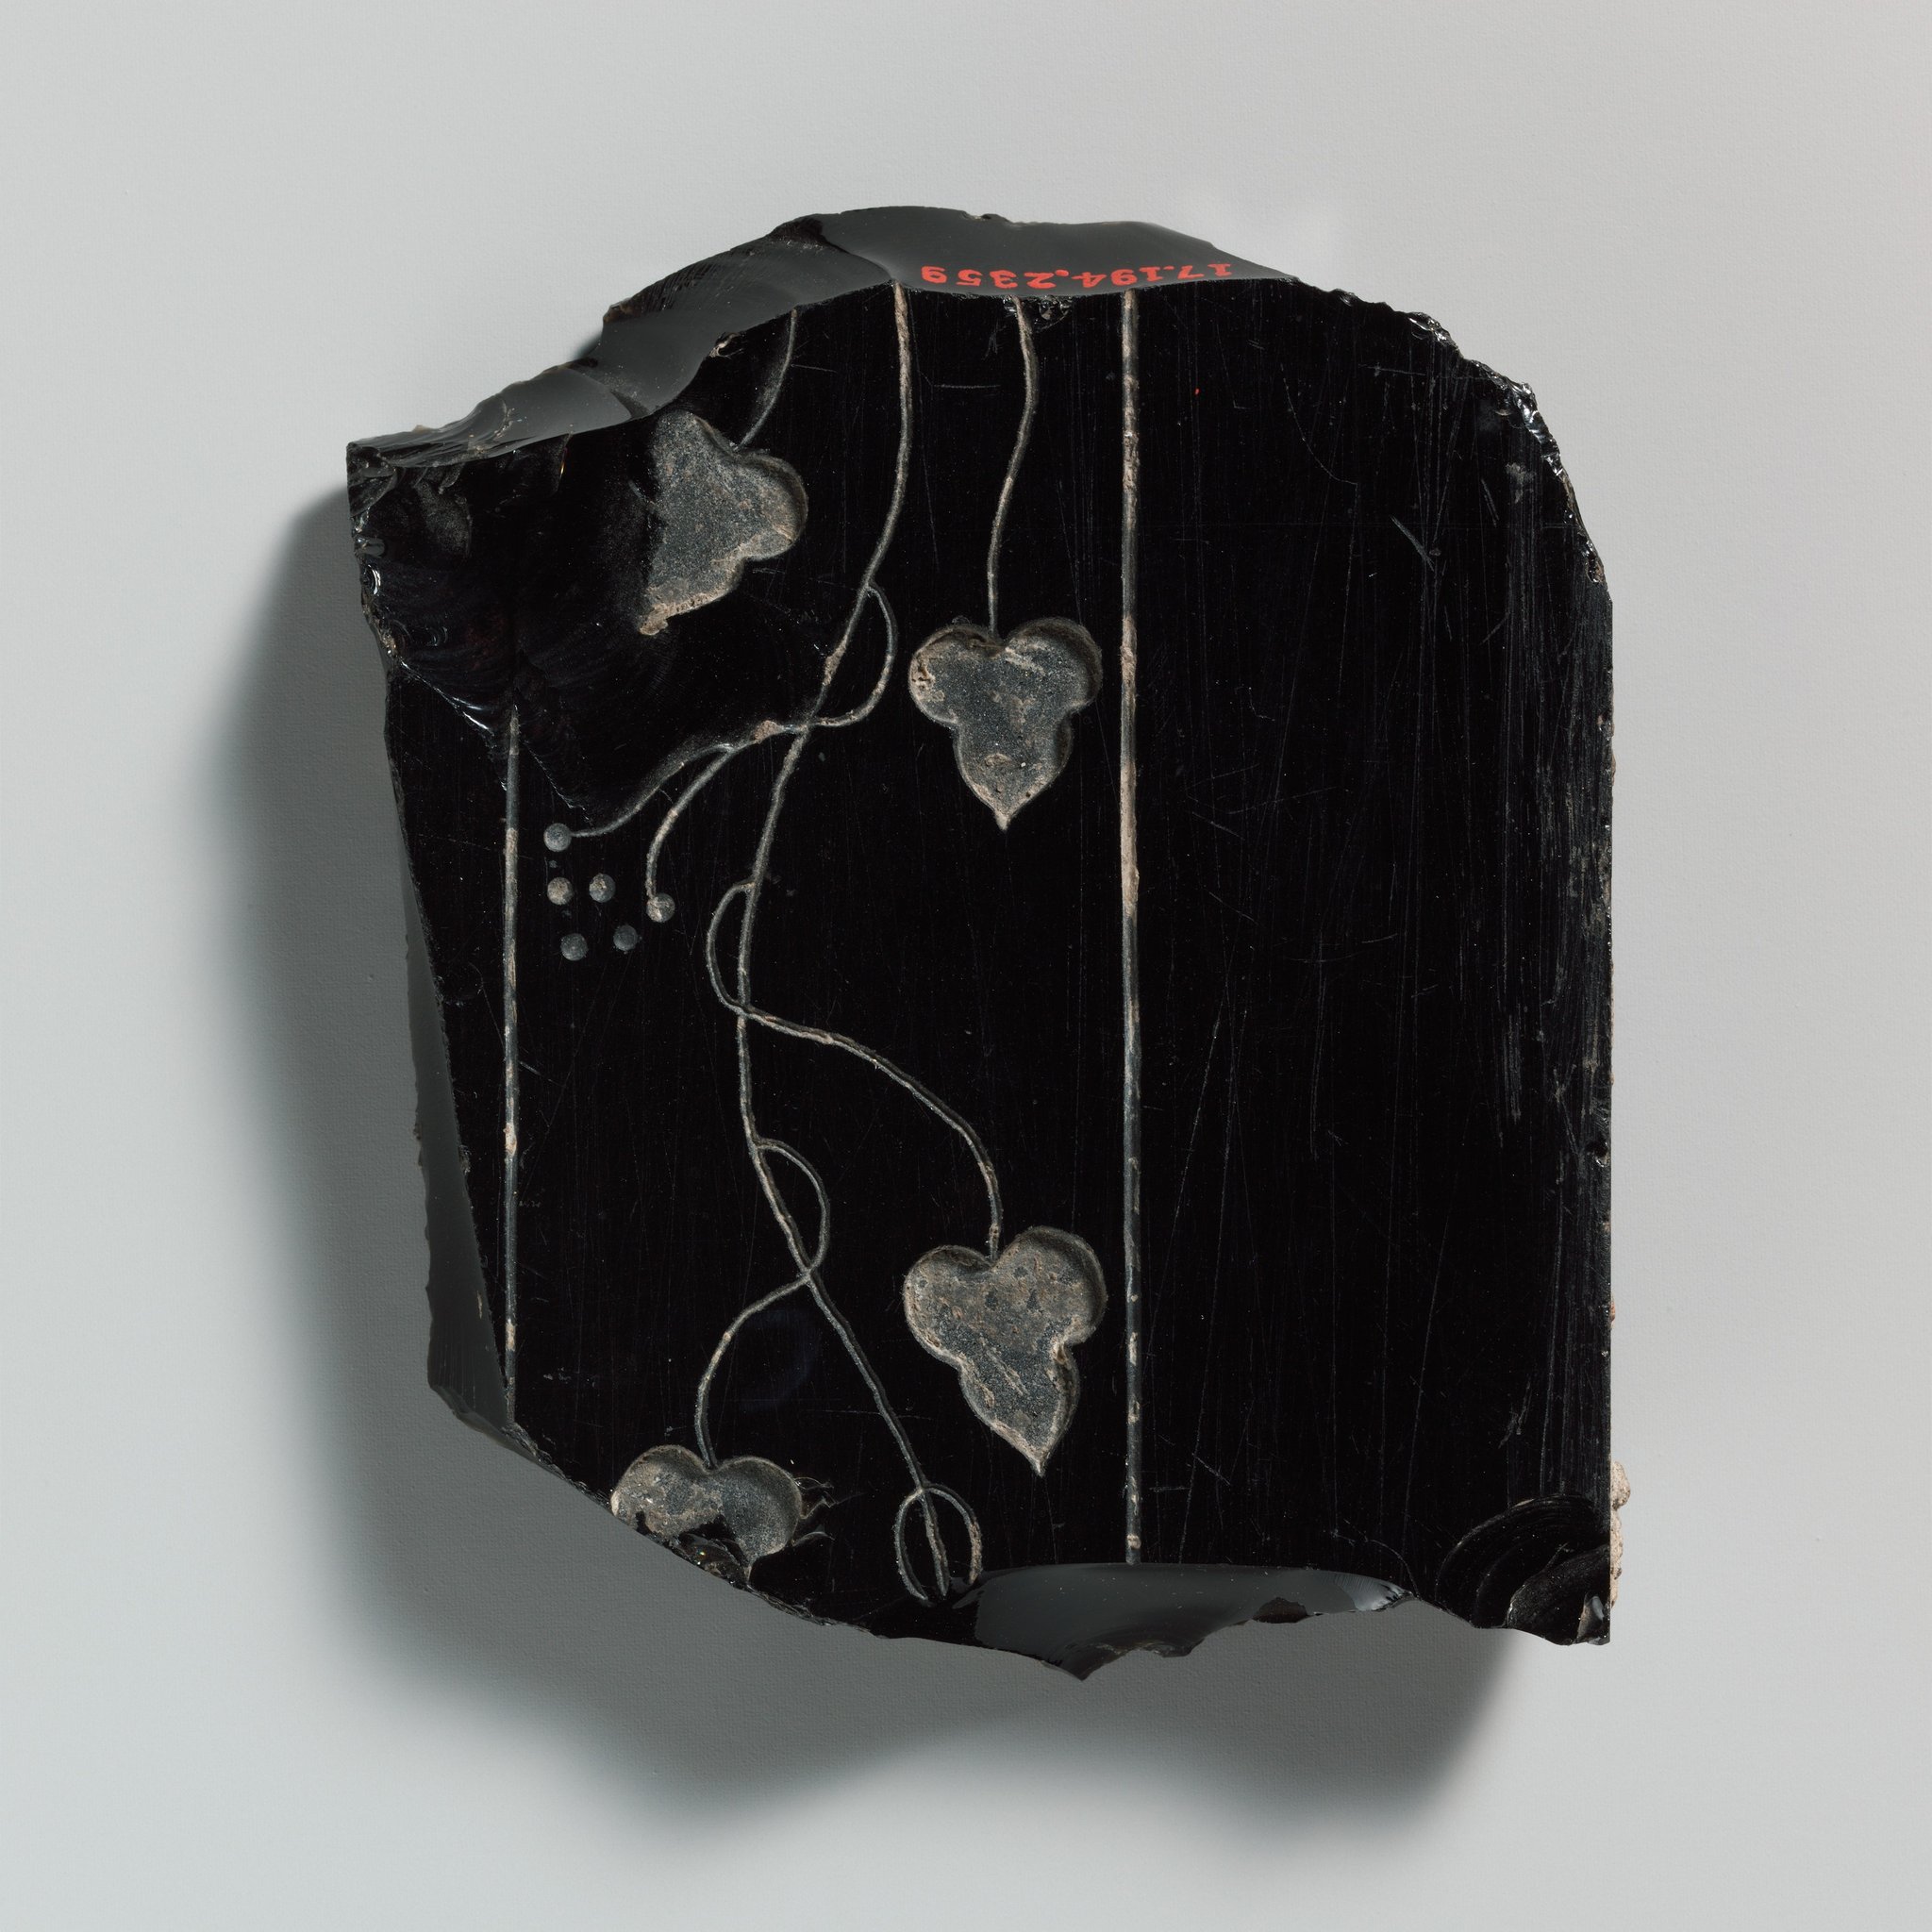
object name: revetment slab fragment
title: Obsidian revetment slab fragment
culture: roman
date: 1-100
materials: obsidian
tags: leaves